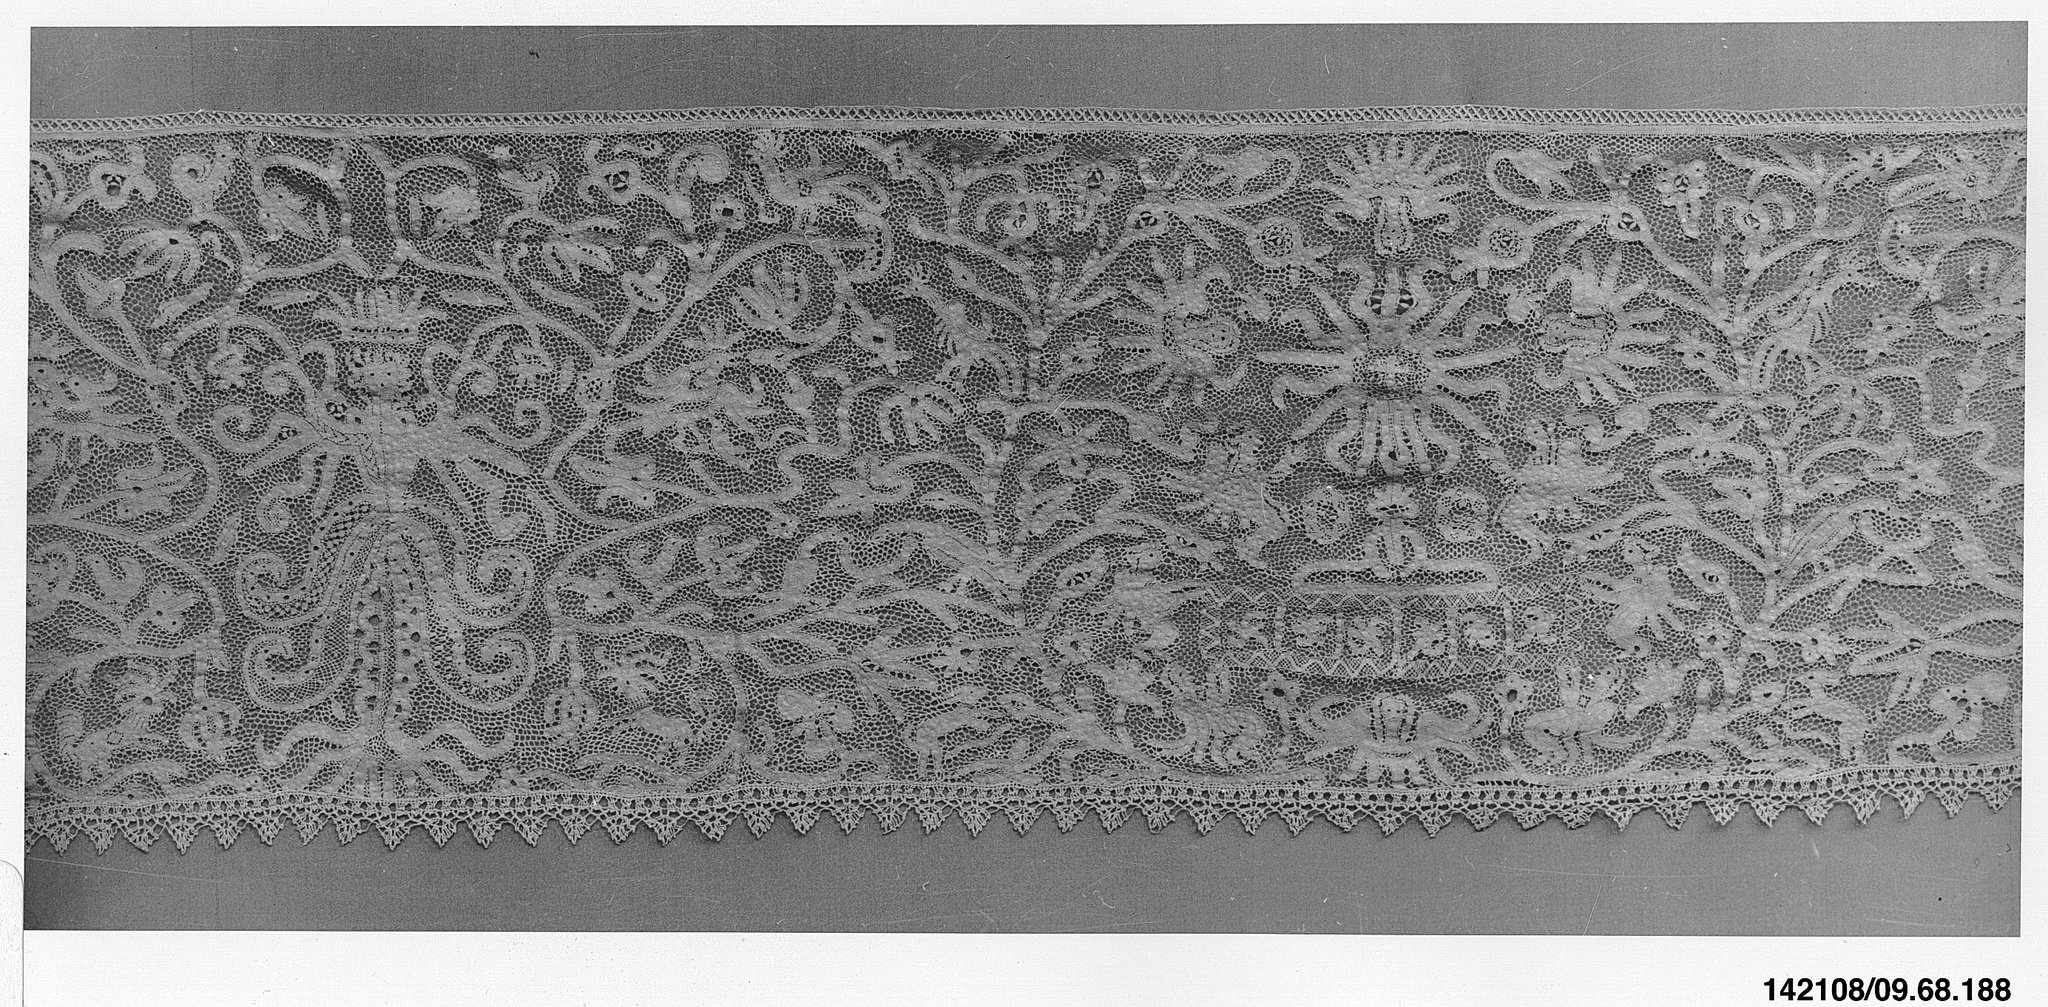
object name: border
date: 1667-1700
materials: lace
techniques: lace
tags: animals,flowers